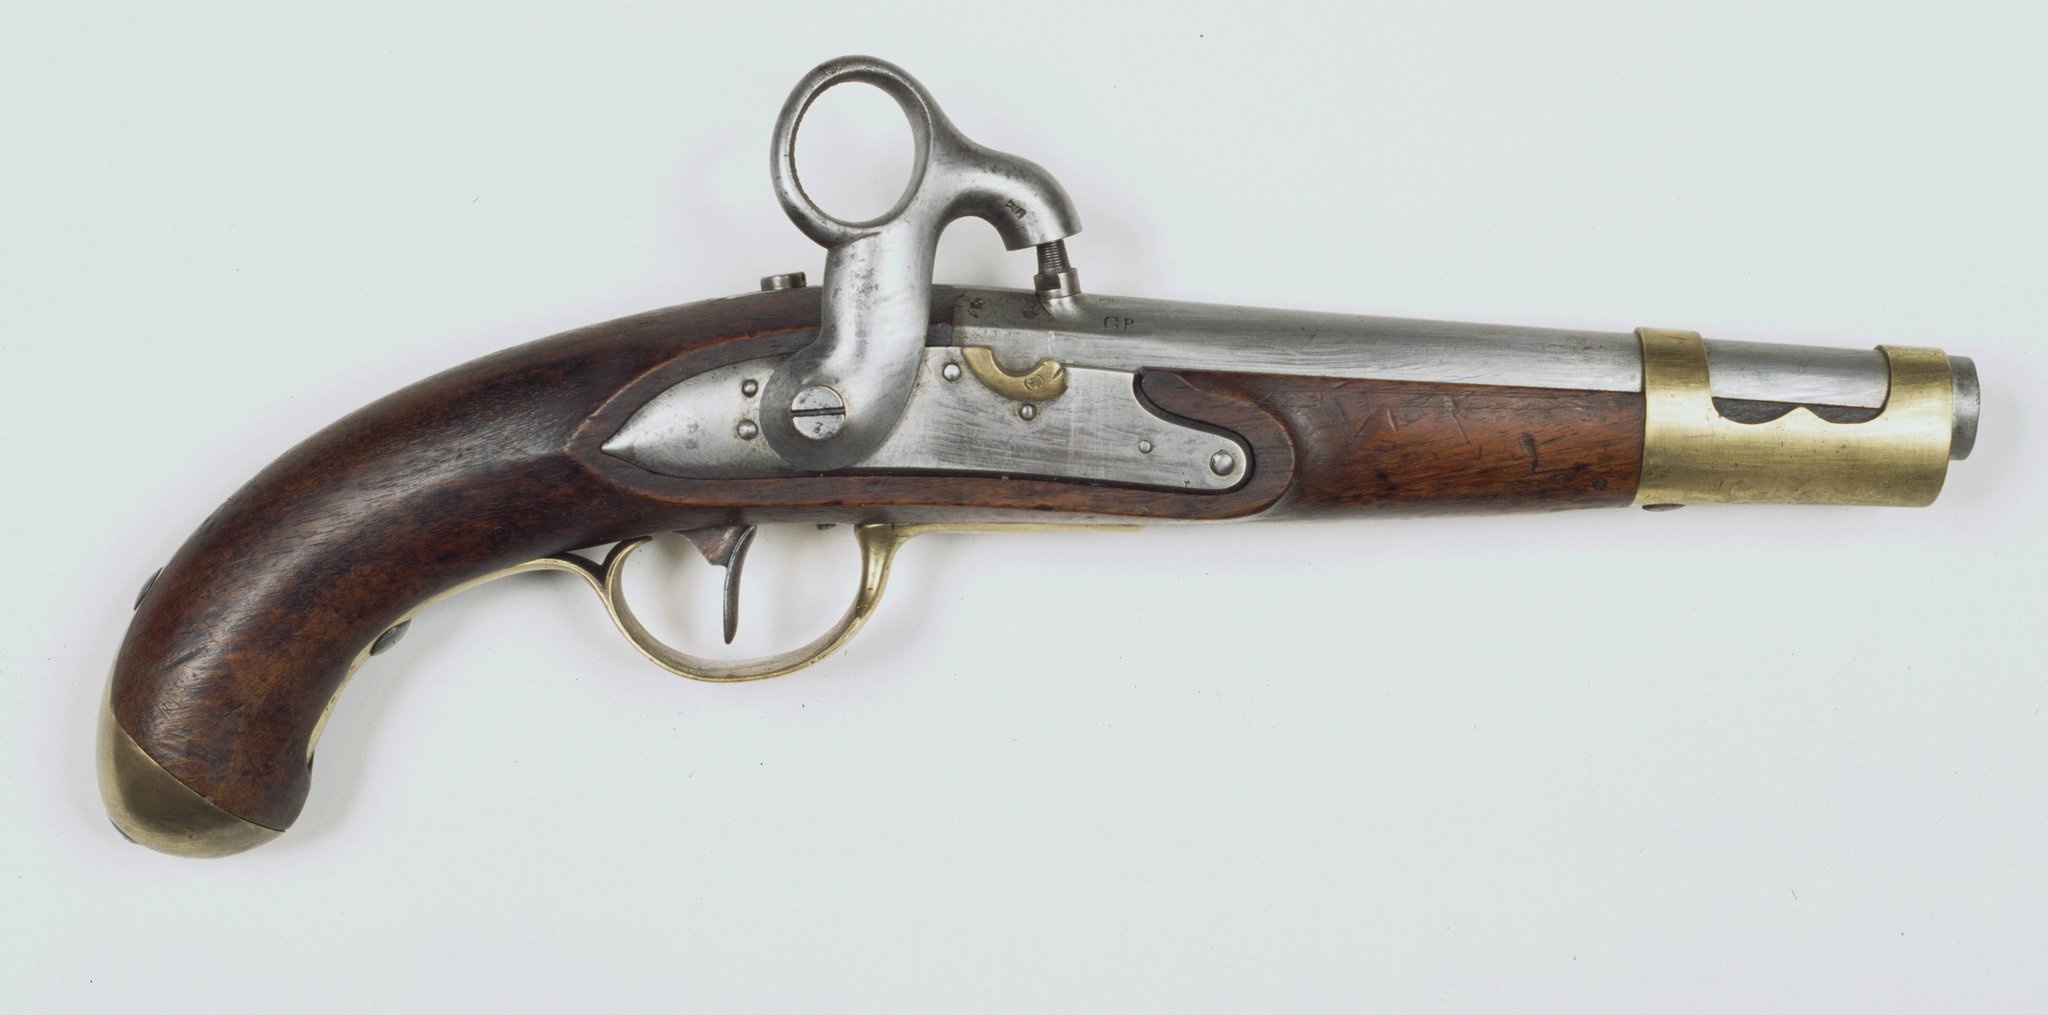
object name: percussion pistol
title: Percussie legerpistool model M 1815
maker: Anonymous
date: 1815-1816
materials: brass, iron, wood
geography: netherlands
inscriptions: mark: ‘G’